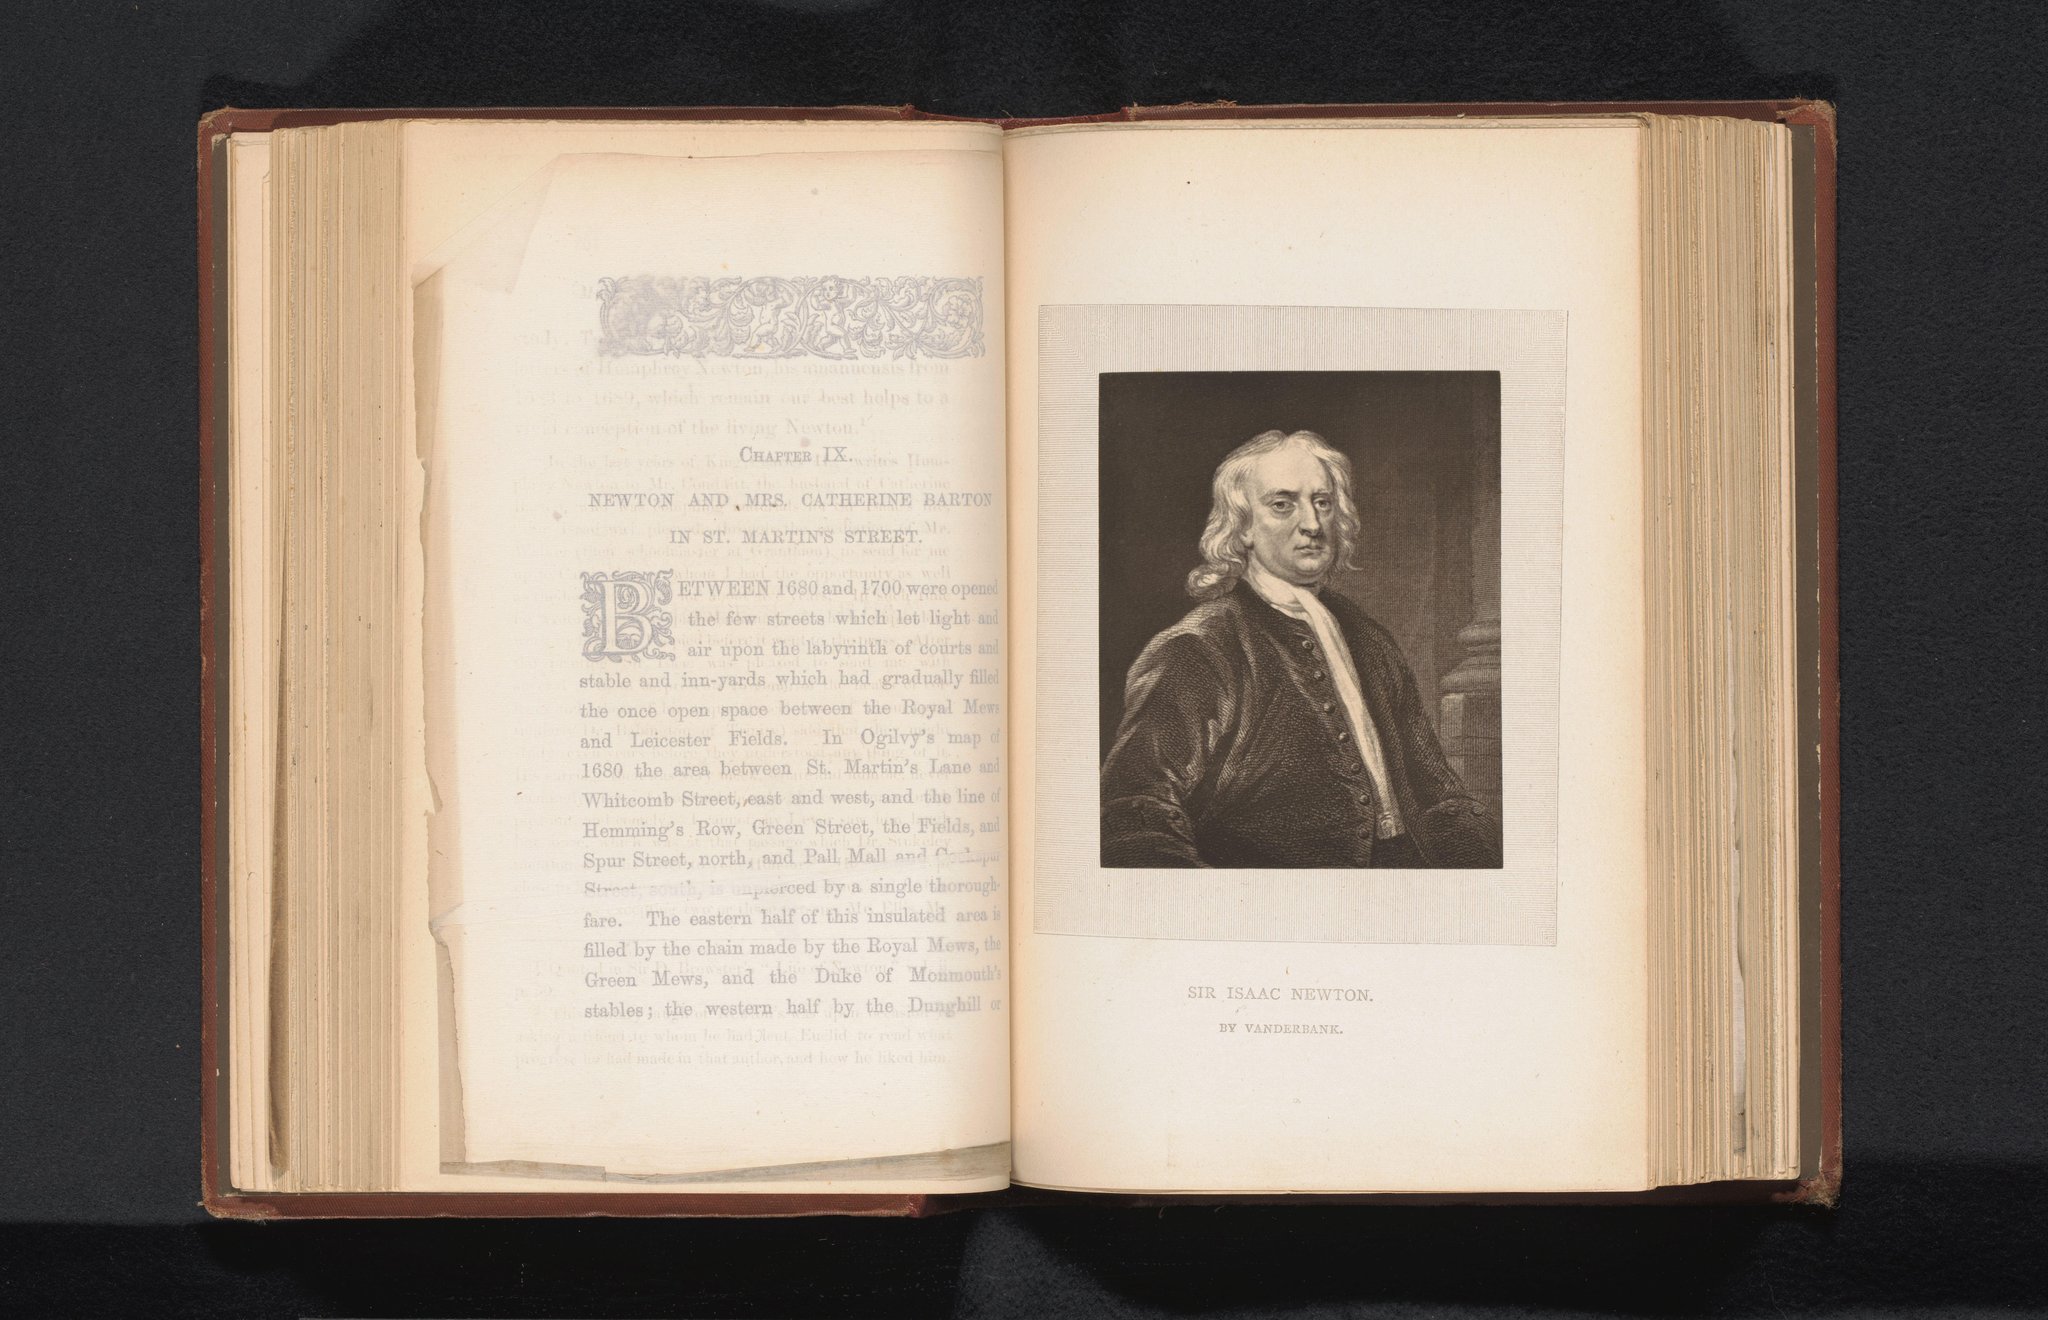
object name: reproduction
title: Sir Isaac Newton by Vanderbank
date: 1869-1874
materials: paper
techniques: woodburytype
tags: london, physicist, scholar, philosopher